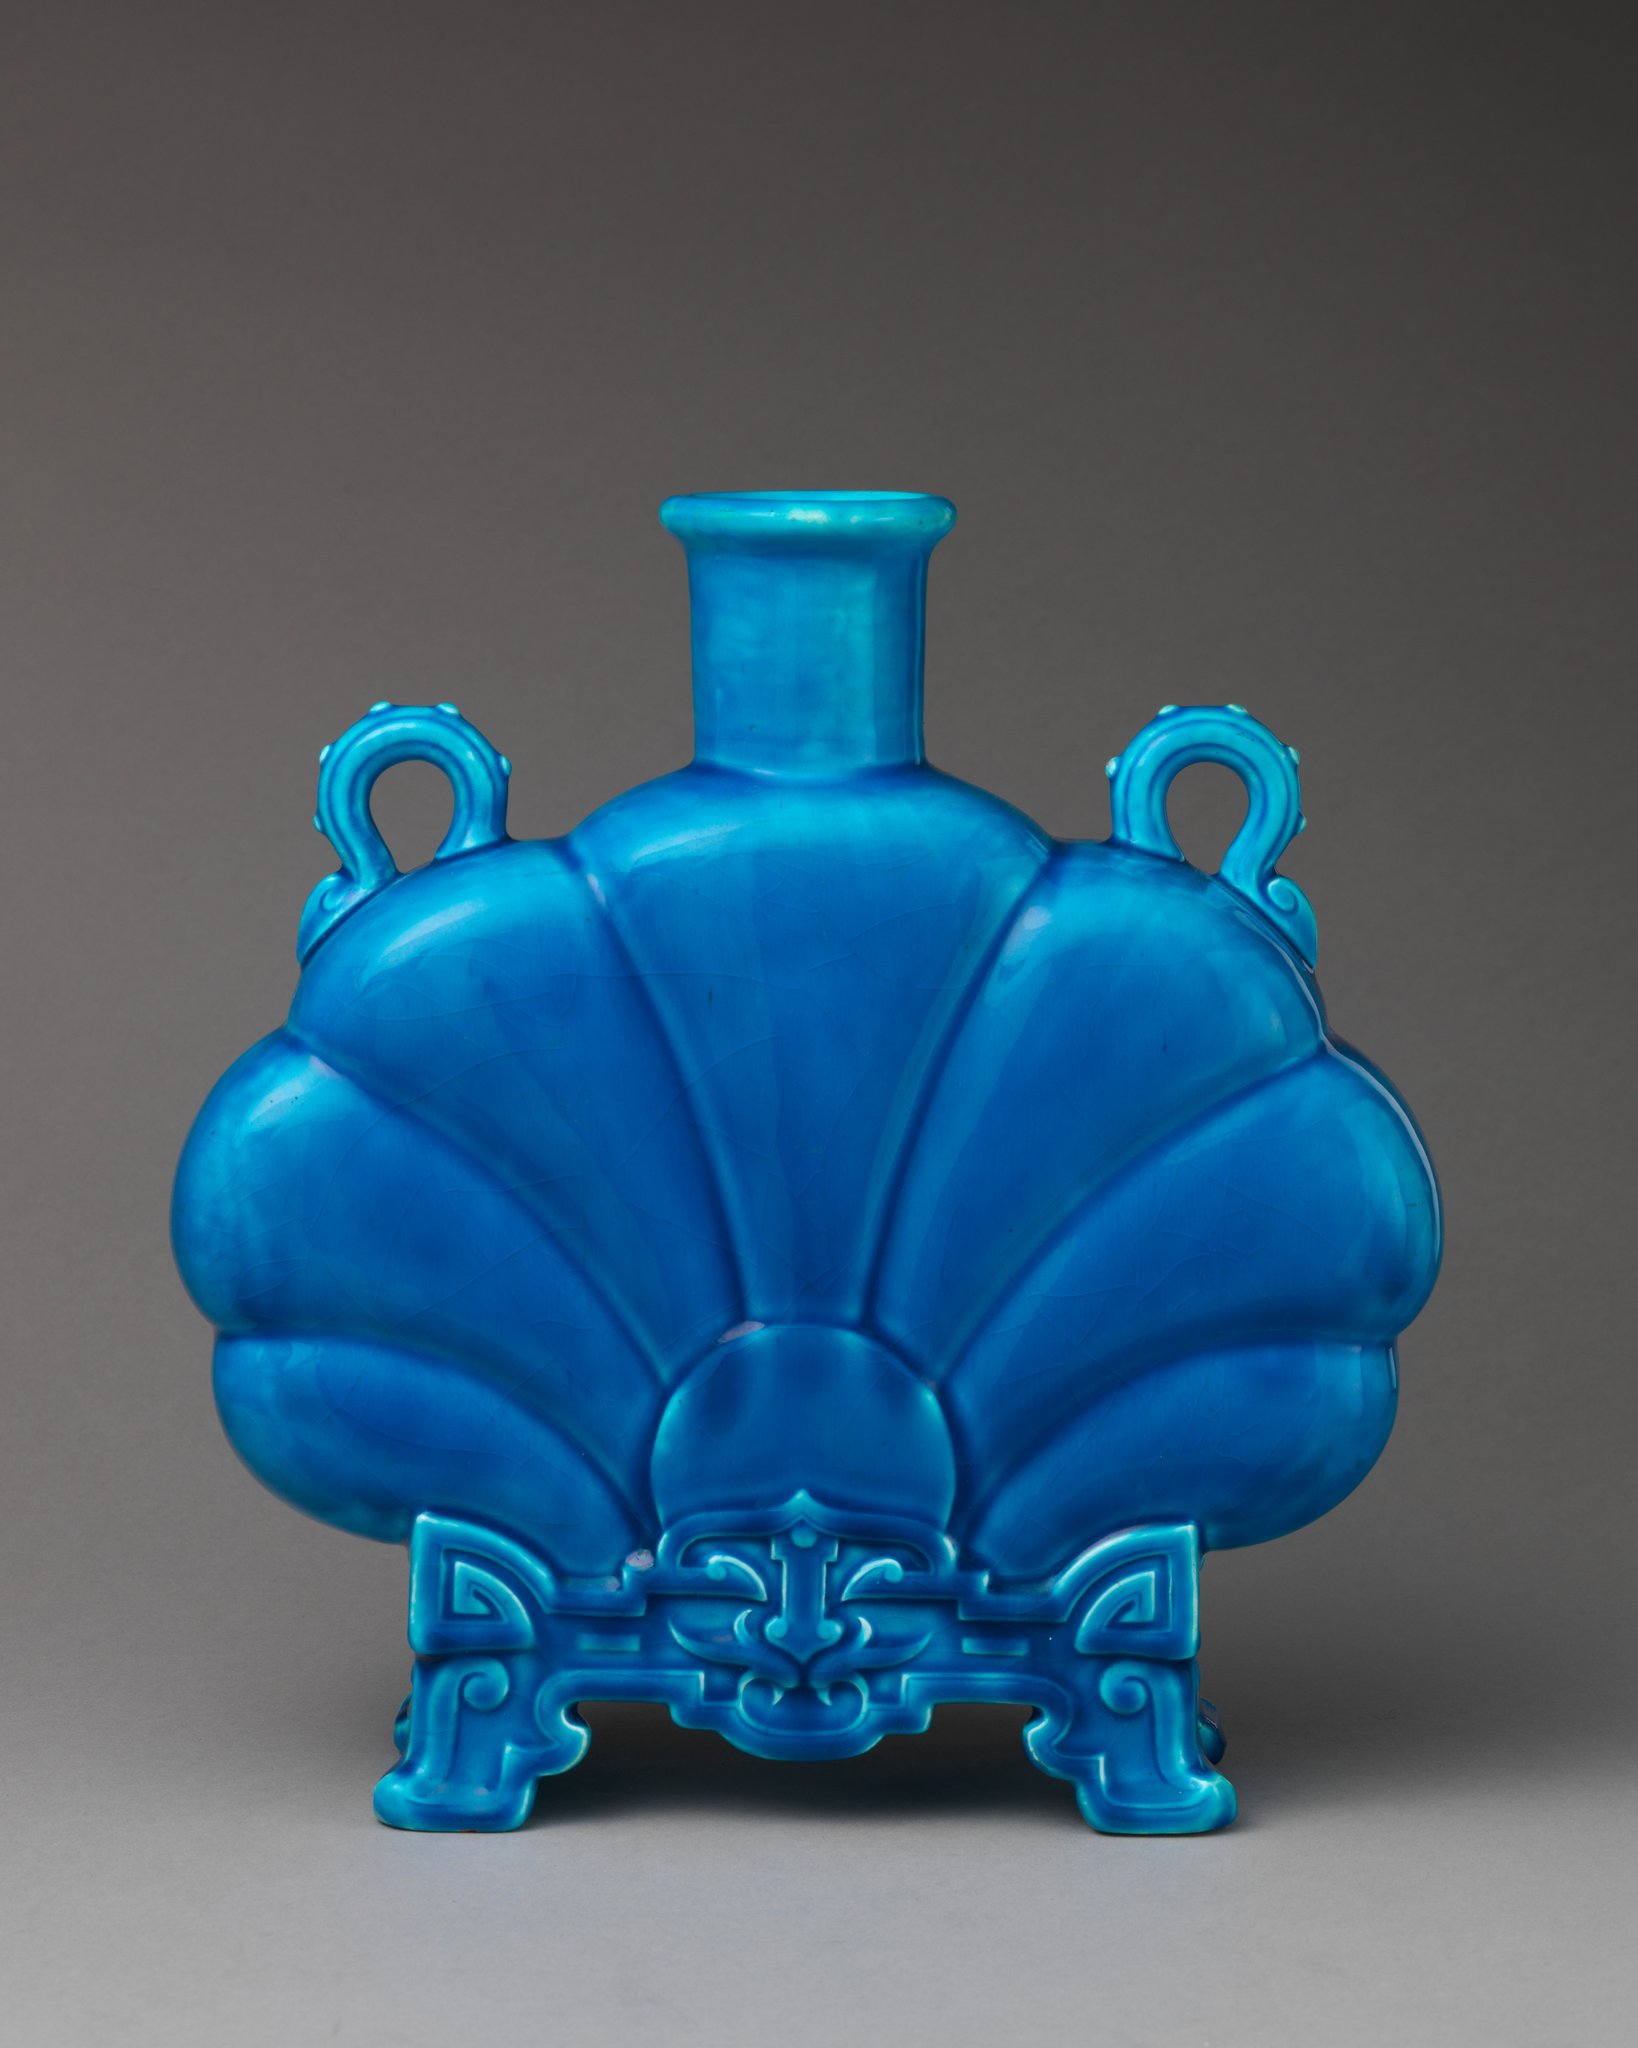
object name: bottle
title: Fan-shape 'Persian' bottle with handles (one of a pair)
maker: minton(s)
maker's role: maker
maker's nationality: british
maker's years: 1793-2001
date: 1872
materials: earthenware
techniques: glazing